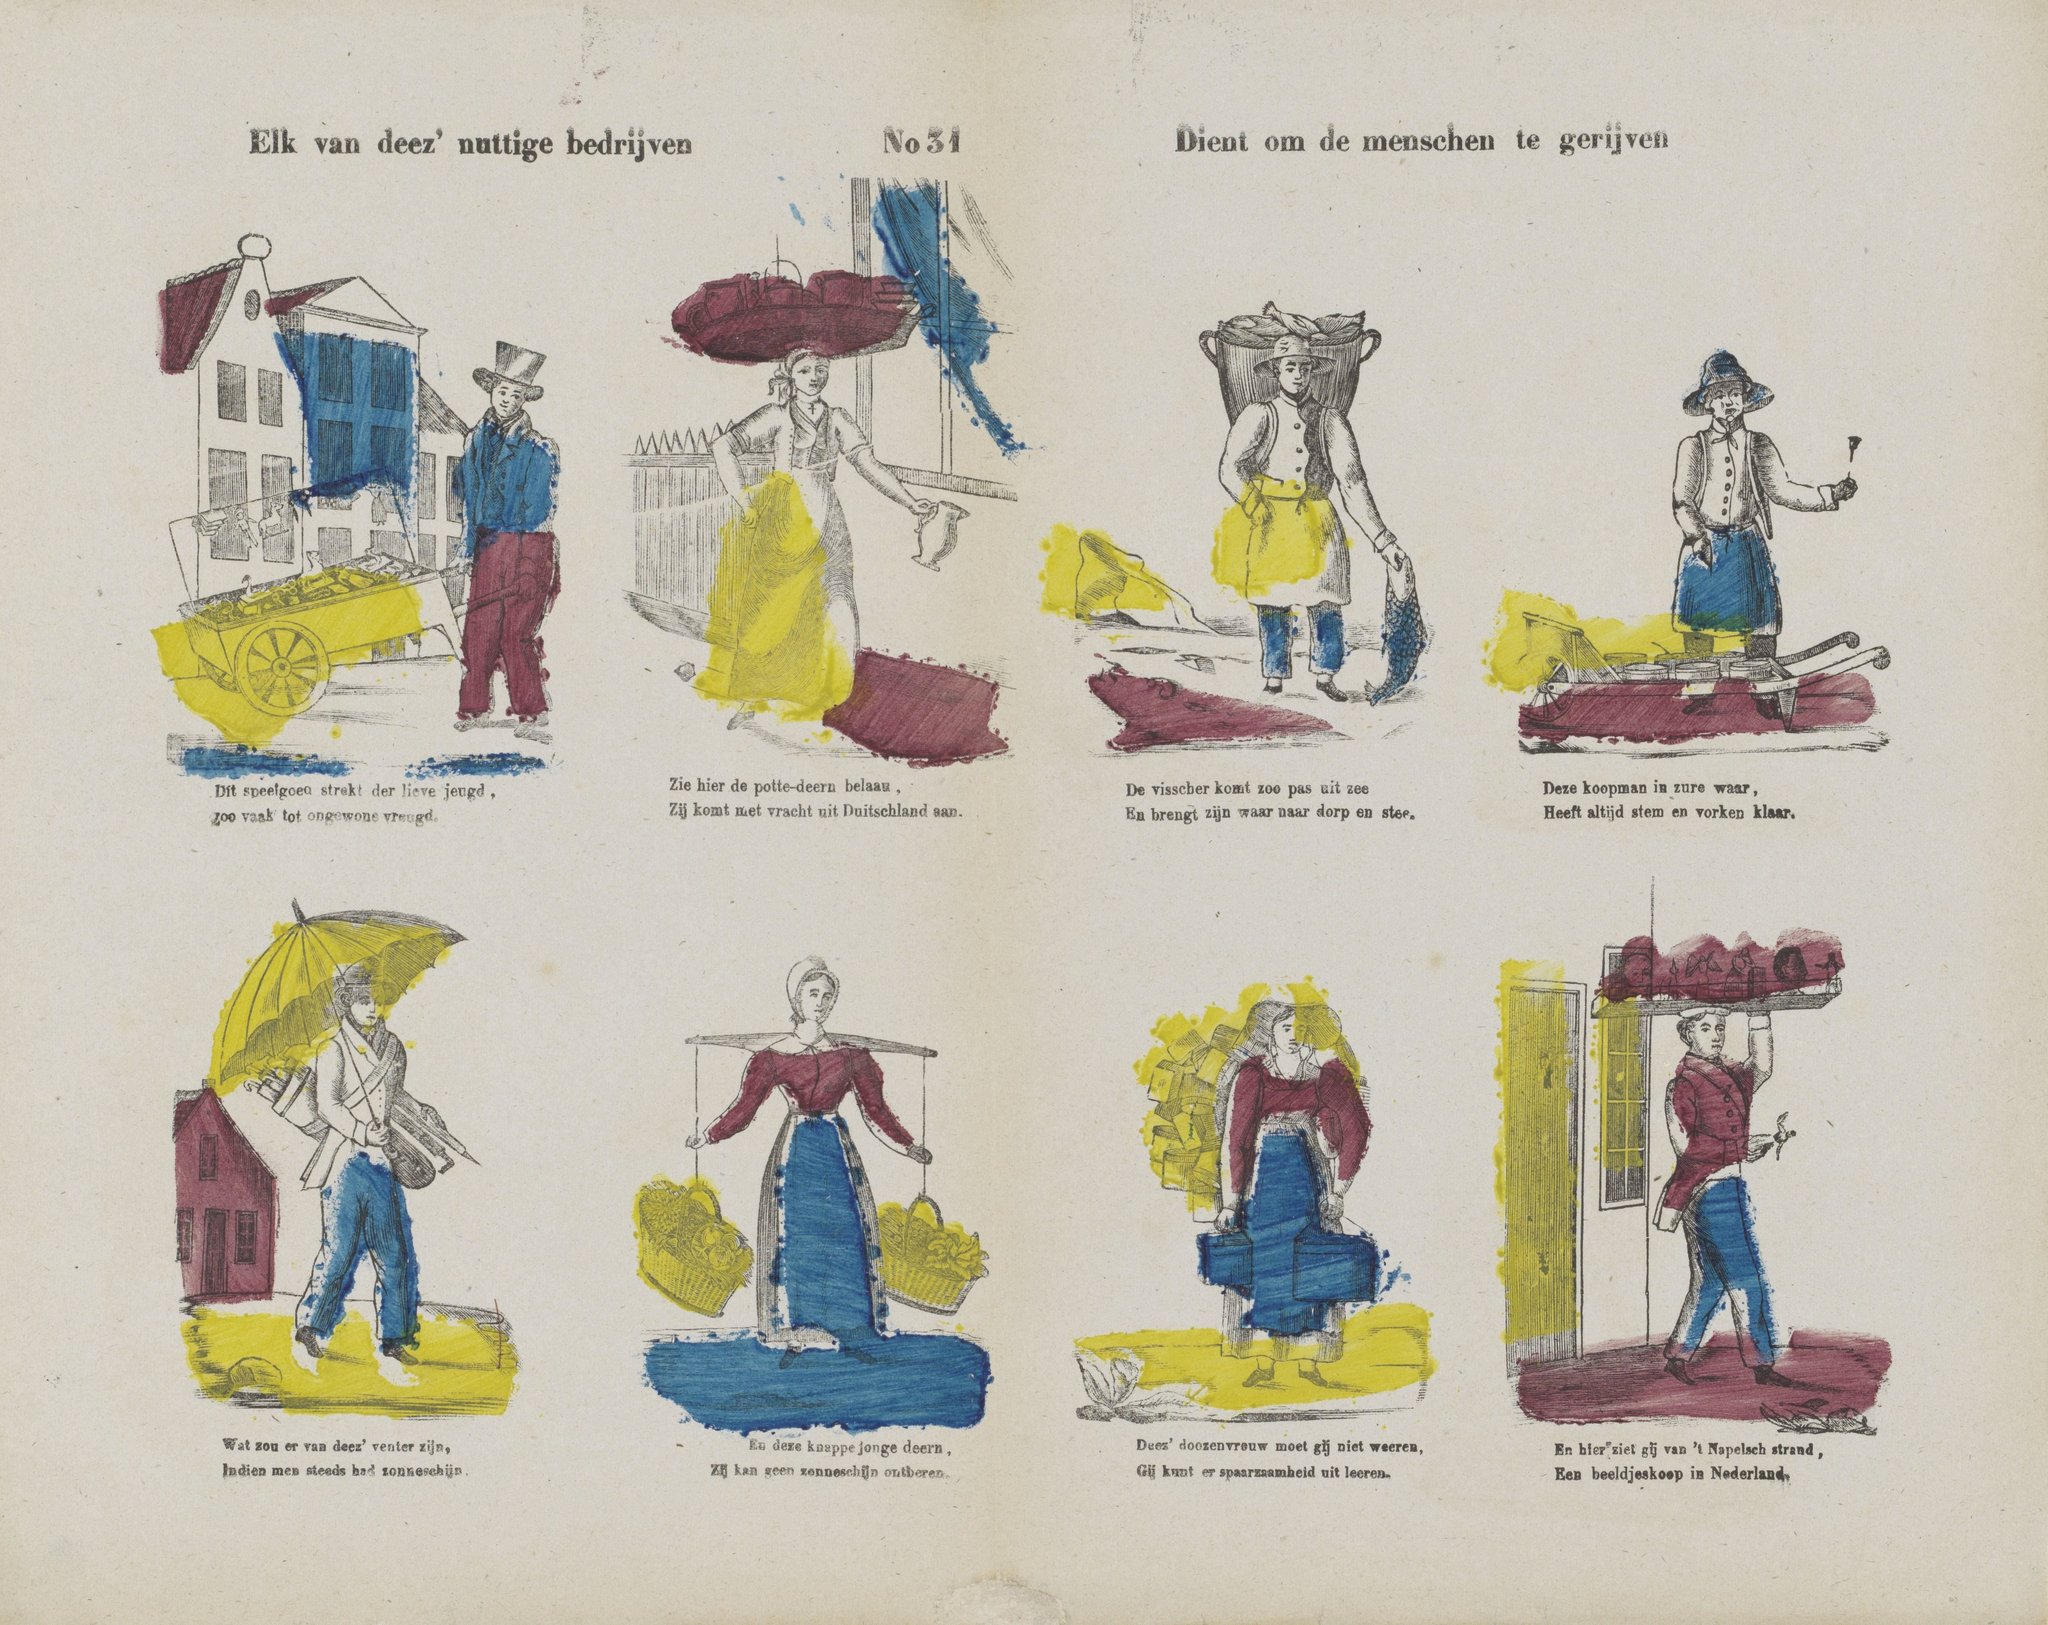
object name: popular print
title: Elk van deez' nuttige bedrijven / Dient om de menschen te gerijven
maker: Anonymous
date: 1848-1881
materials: paper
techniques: colour, letterpress printing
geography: netherlands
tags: street-trader, merchant, salesman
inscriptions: collector's mark: Lugt 2760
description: Blad met 8 voorstellingen van straatverkopers. Onder elke afbeelding een tweeregelig vers. Genummerd midden boven: No 31.